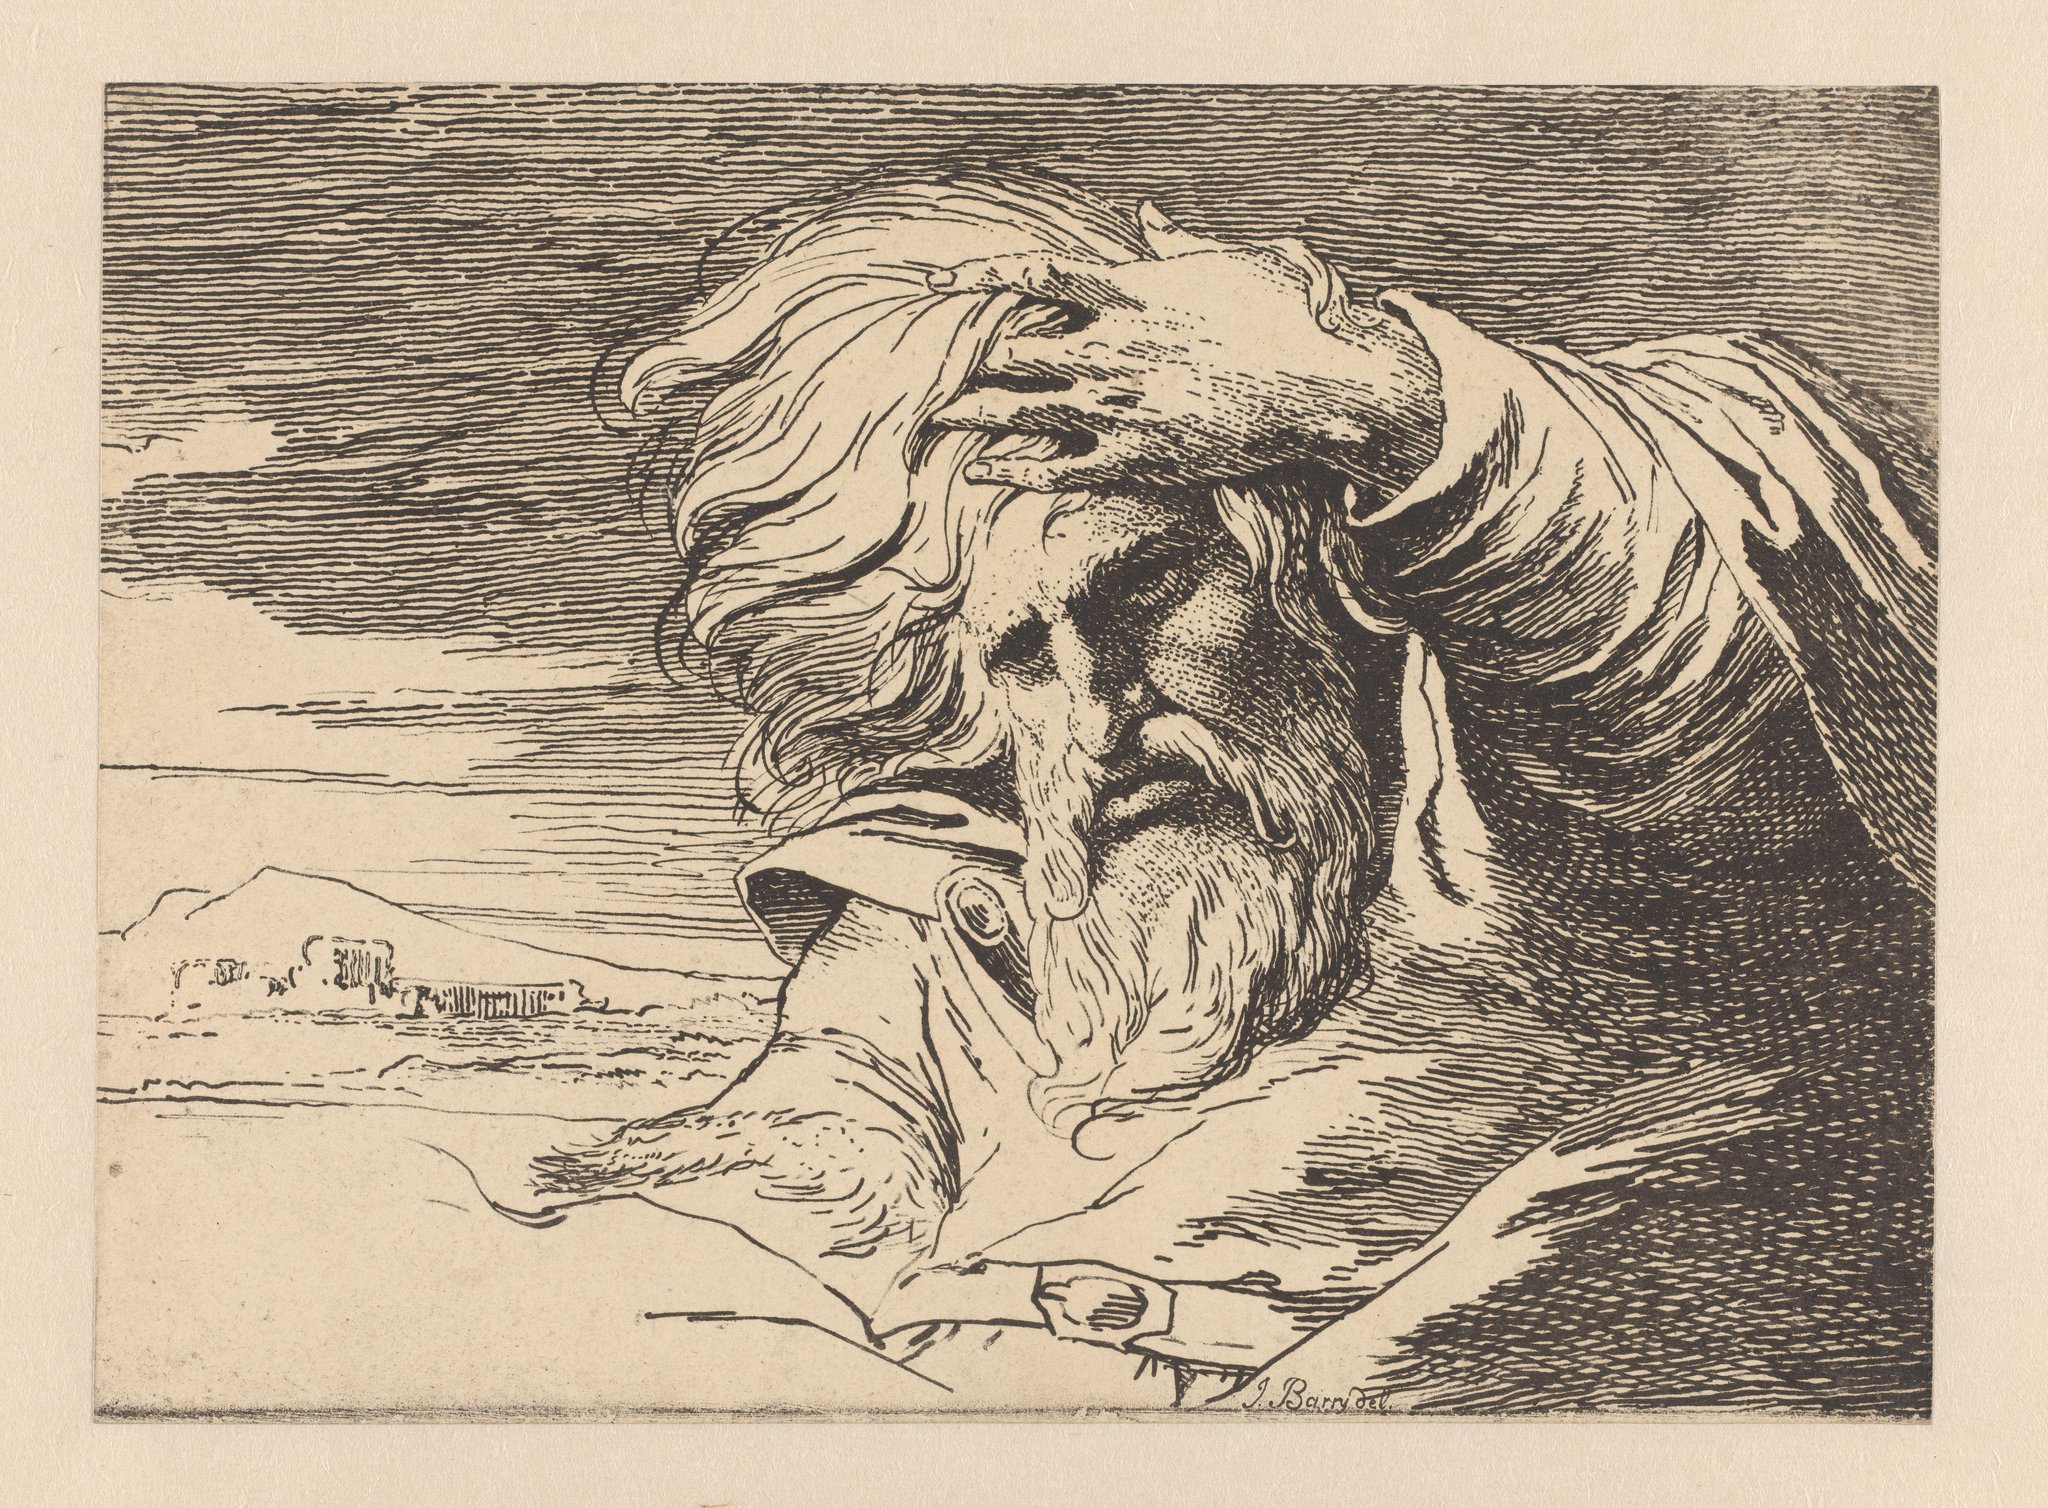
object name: print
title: King Lear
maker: james barry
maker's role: draughtsman, print maker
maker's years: 1741-1806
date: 1803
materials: paper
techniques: pen lithography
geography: london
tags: king lear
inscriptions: collector's mark: Lugt 2760, collector's mark: Lugt 2228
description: De afbeelding is gebaseerd op een eigen schilderij van James Barry, King Lear en Cordelia (1774) of zijn eigenhandige ets met hetzelfde onderwerp.